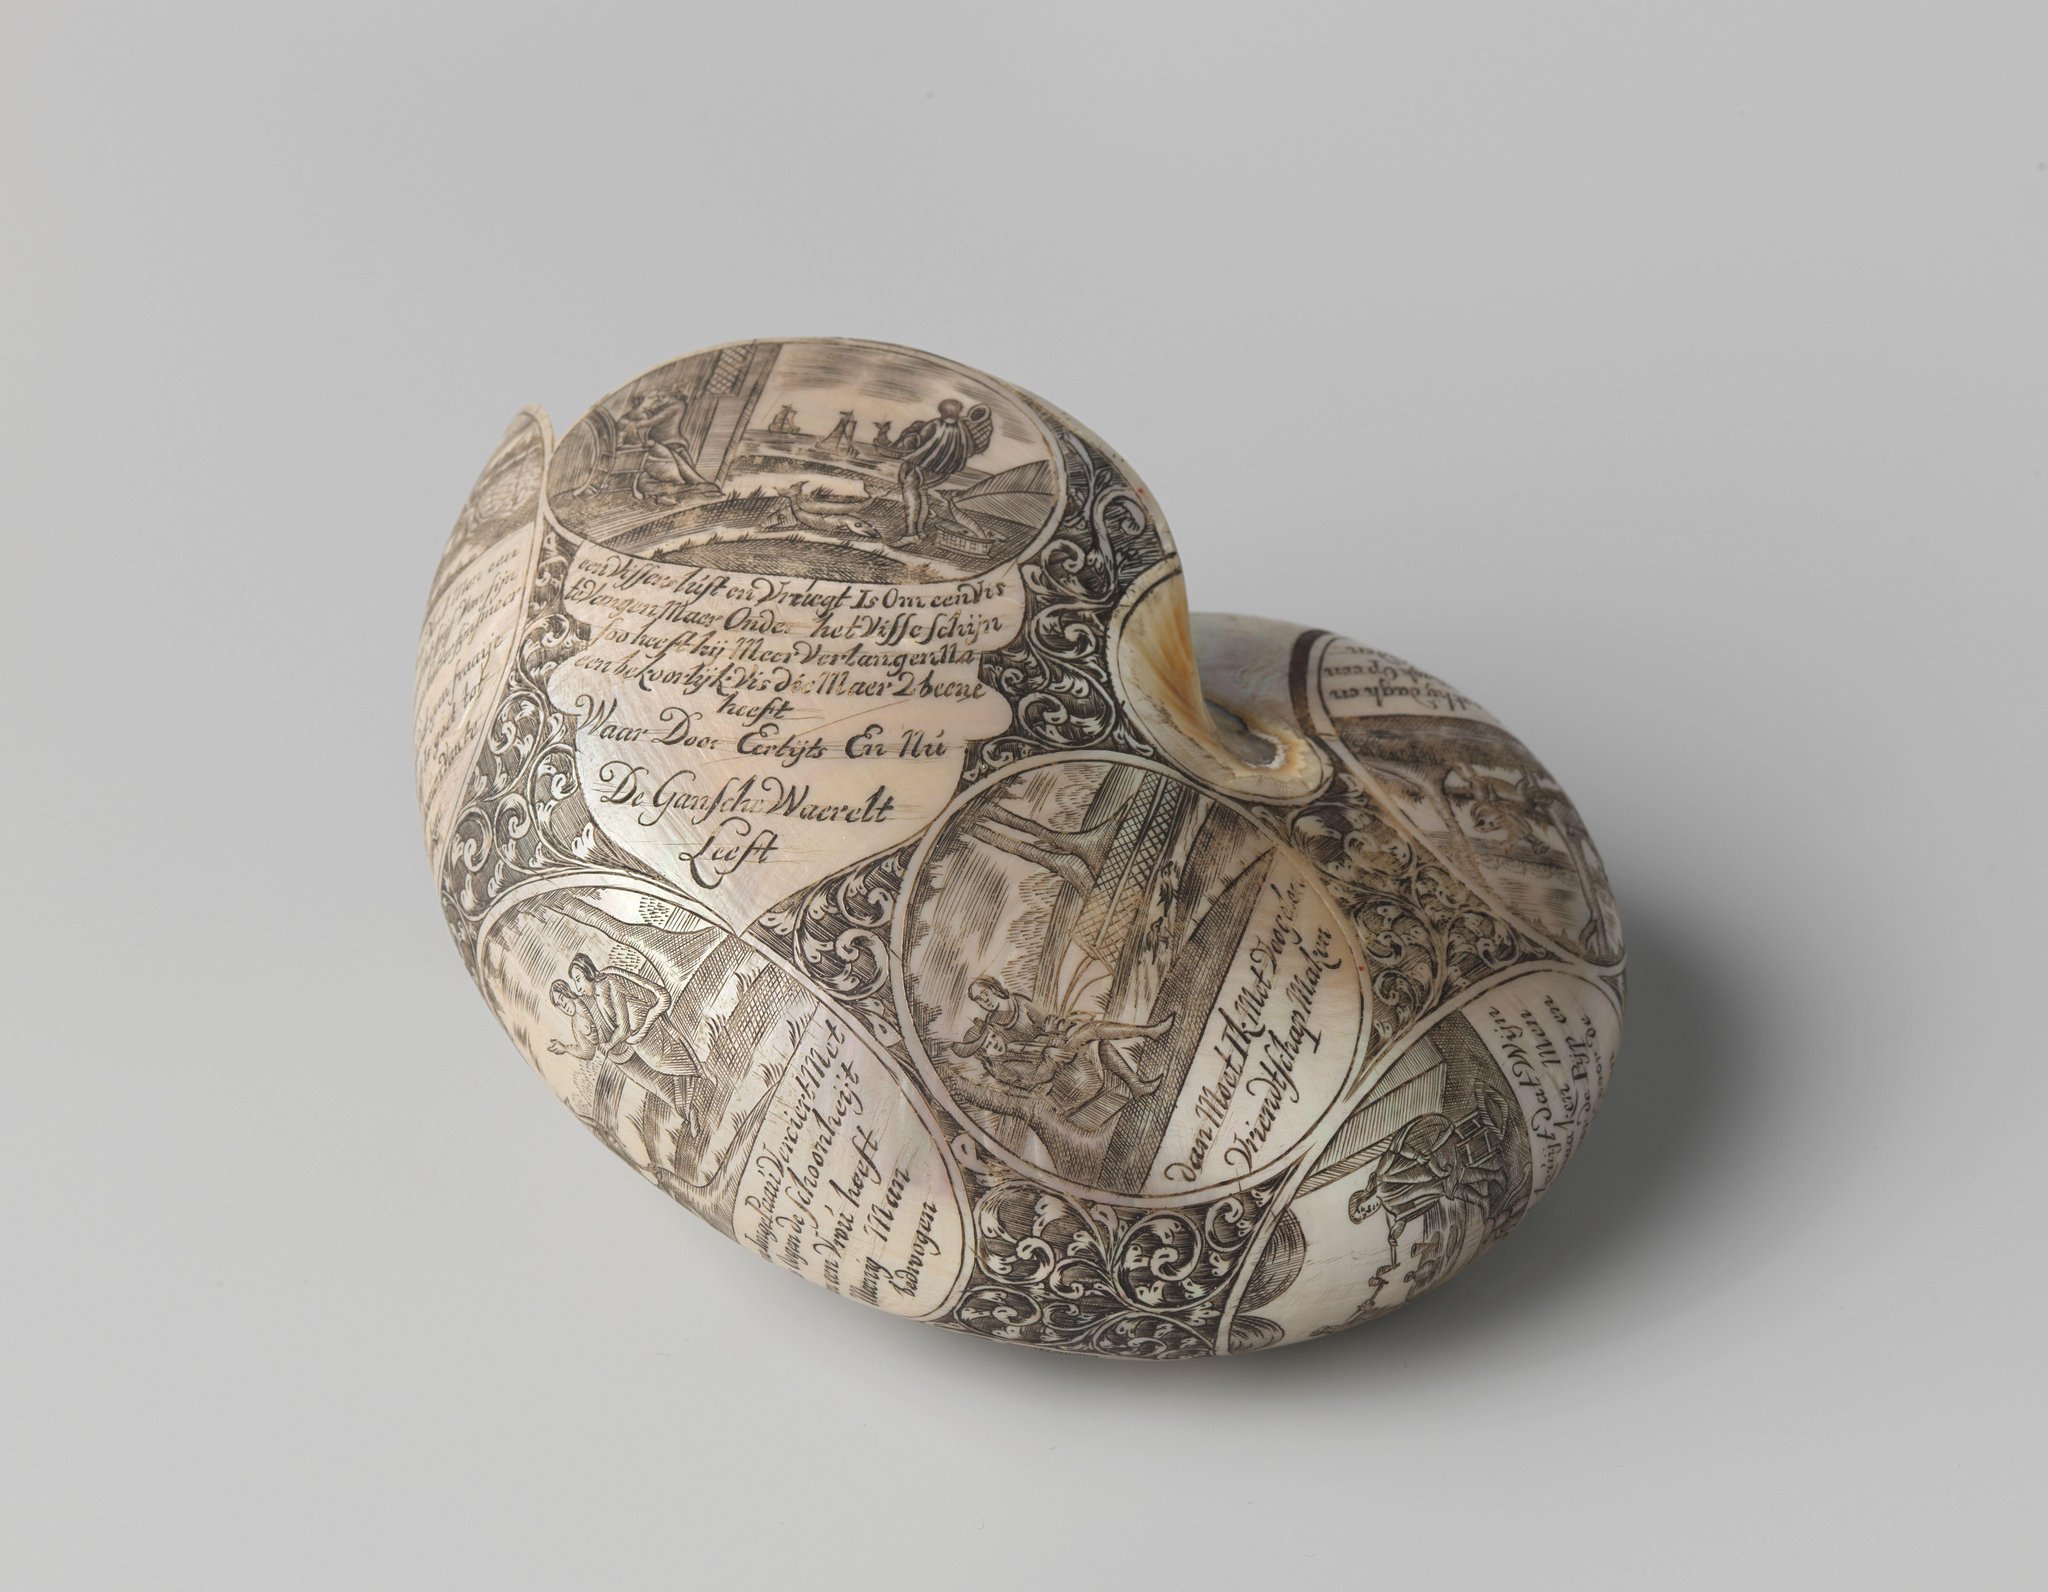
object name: shell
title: Nautilusschelp met gegraveerde cartouches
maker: Anonymous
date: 1700-1725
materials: shell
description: Nautilus shell. Netherlands, early 18th century.